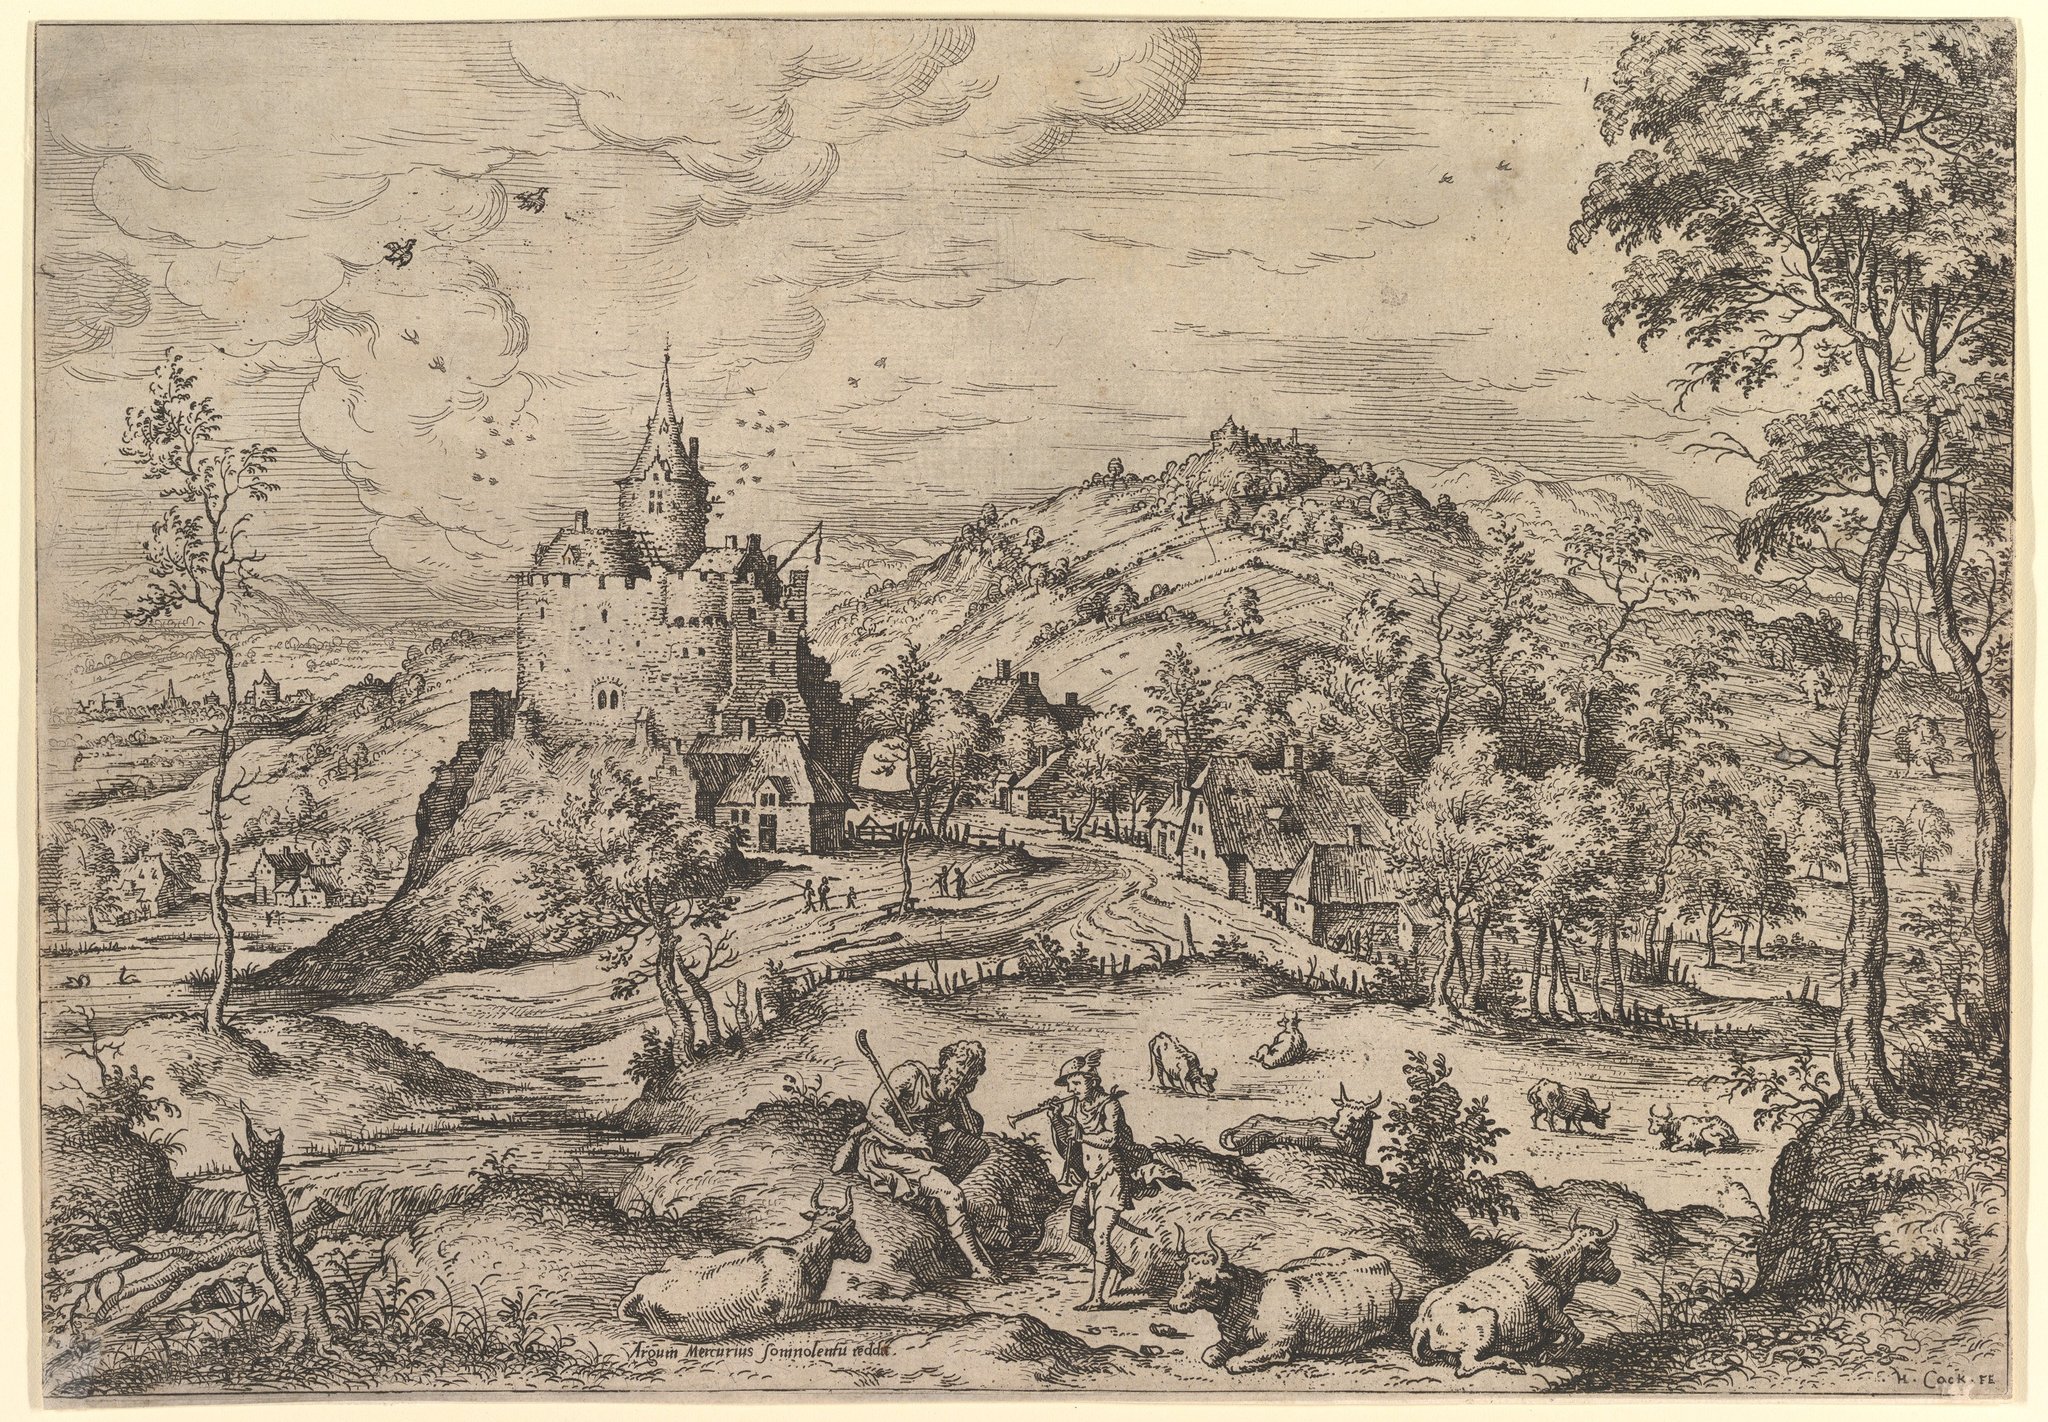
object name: print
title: Mercury Lulling Argus to Sleep, from "Landscapes with Biblical and Mythological Scenes"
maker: hieronymus cock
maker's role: artist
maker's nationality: netherlandish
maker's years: 1510-1570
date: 1558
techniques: etching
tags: castles,mercury,cows,trees